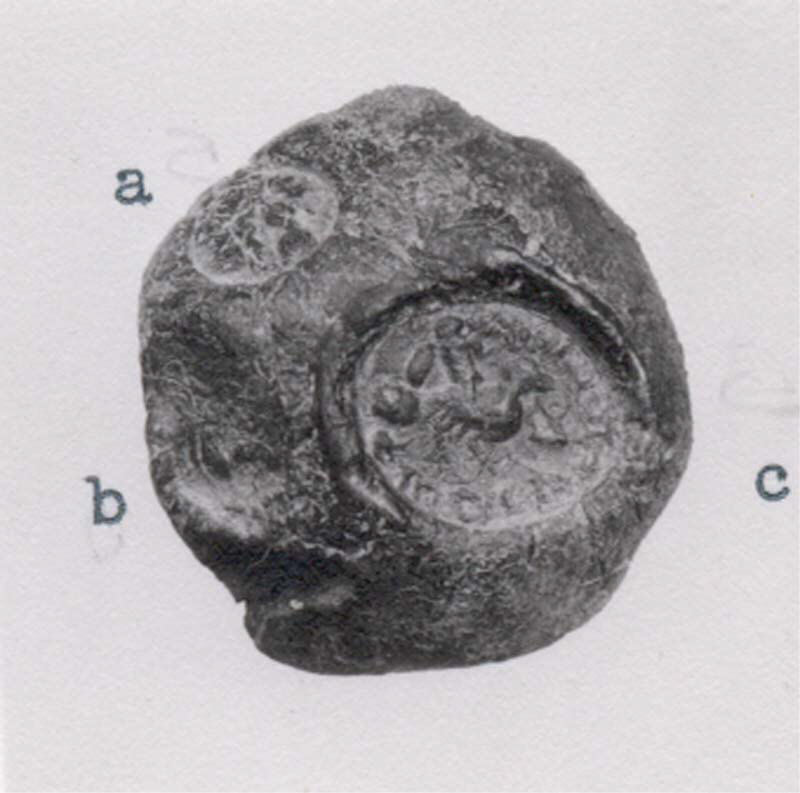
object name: sealing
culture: sasanian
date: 601-700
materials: clay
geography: iran